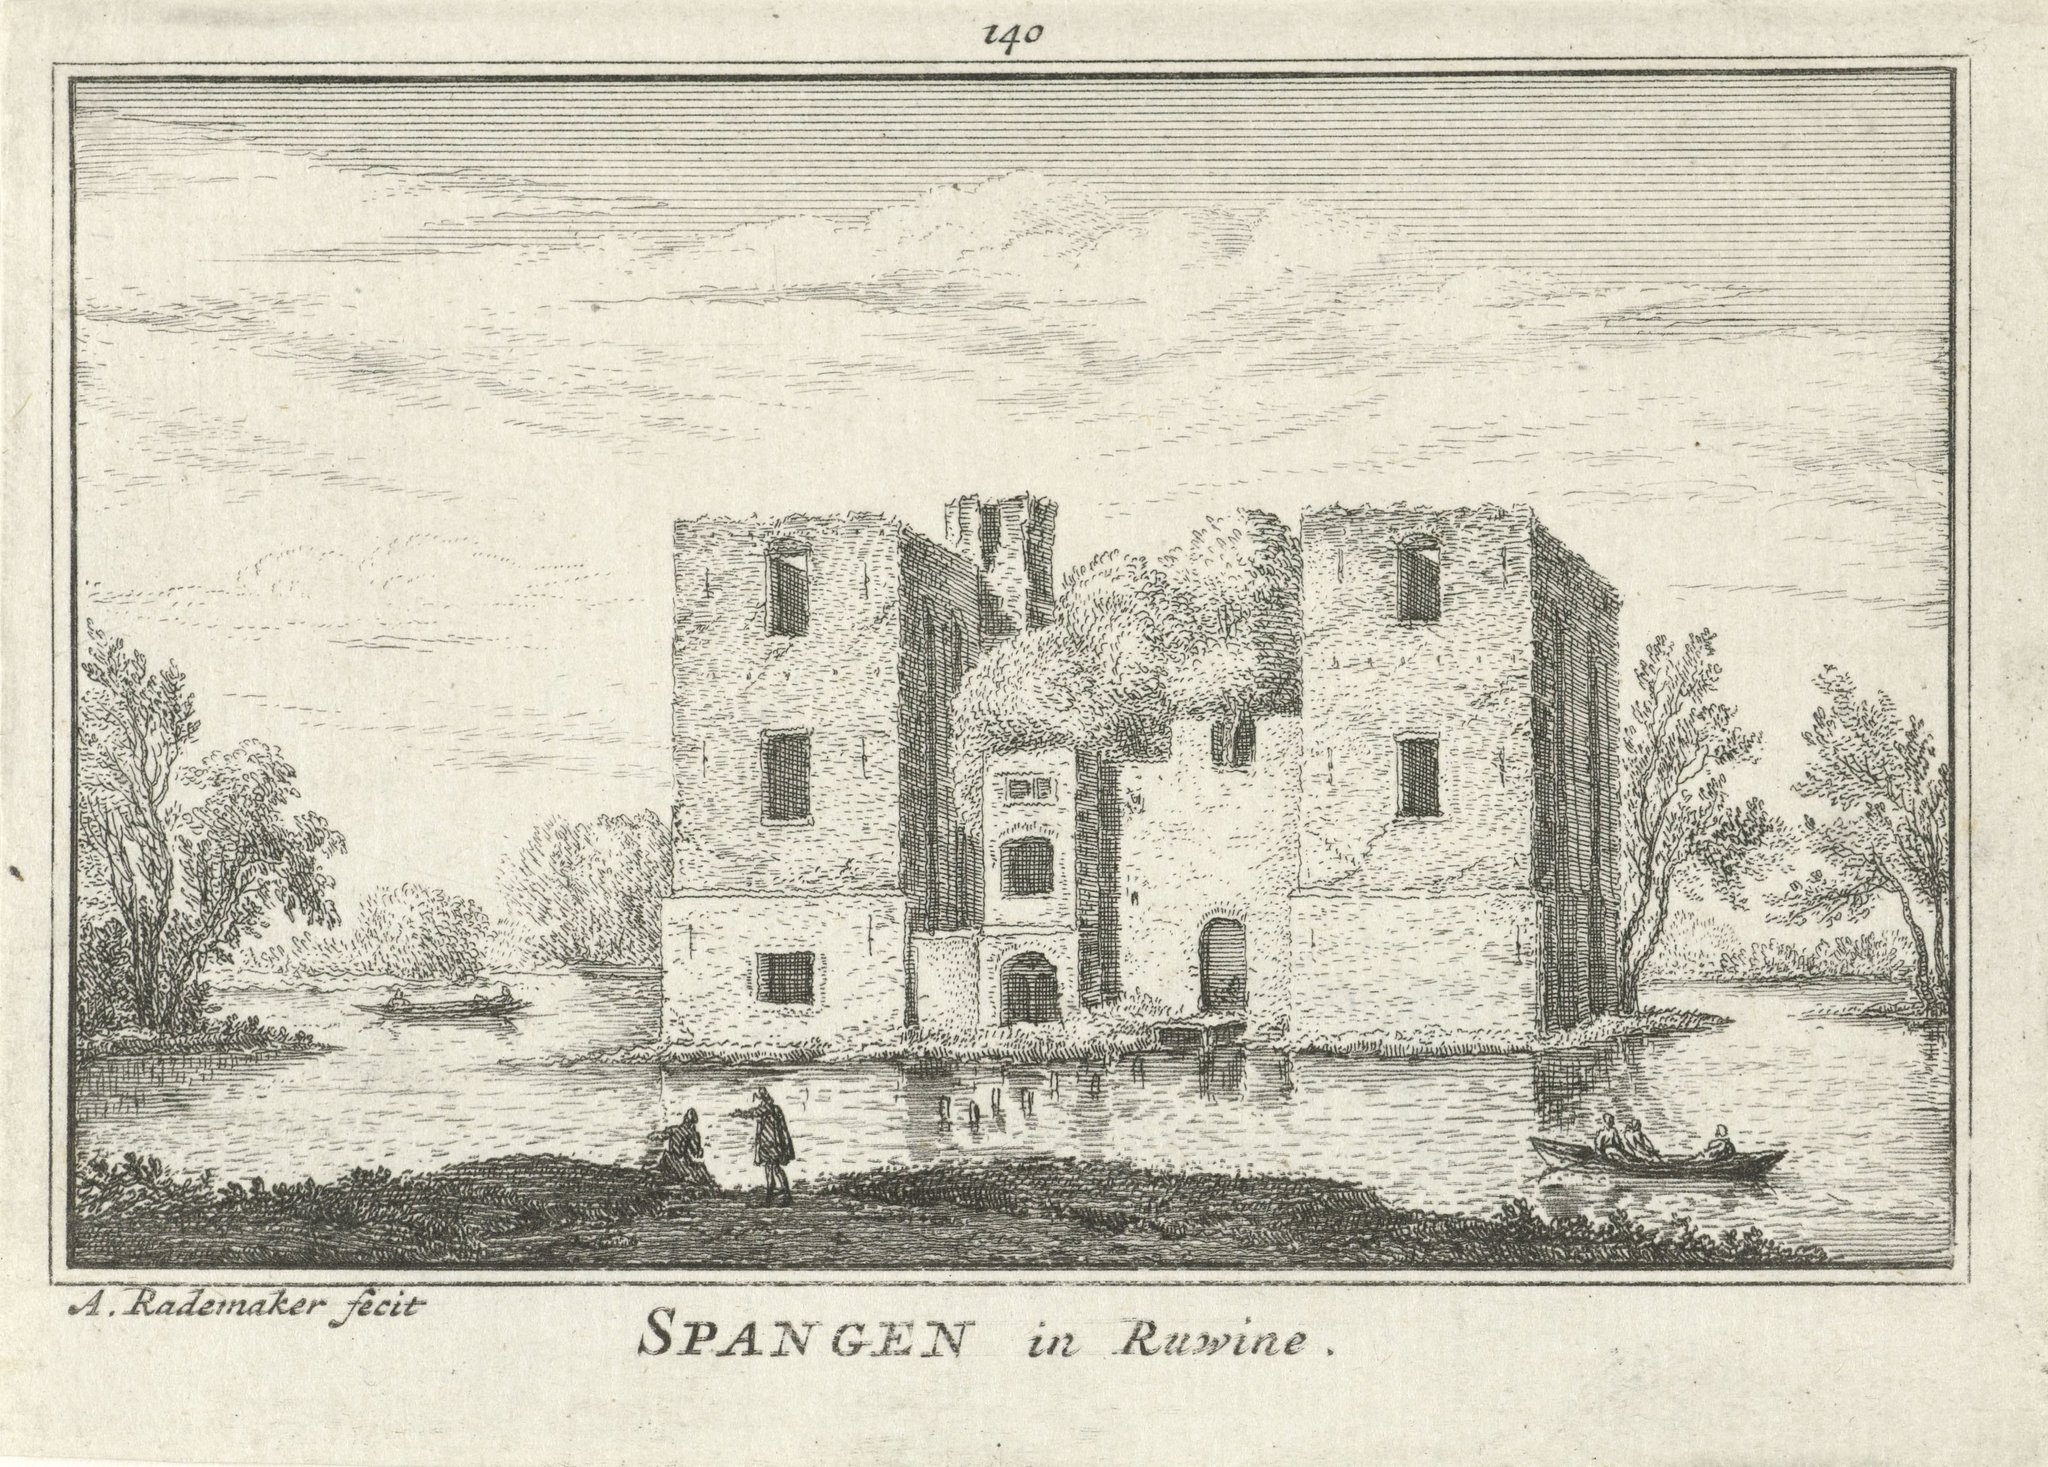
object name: book illustration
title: Gezicht op de ruïne van Kasteel Spangen, 1573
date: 1727-1733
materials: paper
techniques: etching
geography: amsterdam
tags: rowing-boat, canoe, etc., ruin of a dwelling, house, castle, etc.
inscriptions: collector's mark: Lugt 2228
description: Illustratie uit: Abraham Rademaker, Matthaeus Brouërius van Niedek, Isaac Le Long, Kabinet van Nederlandsche en Kleefsche outheden en (...) voorname stads- en landgebouwen, Willem Barents en Antoni Schoonenburg: Amsterdam, 1727-1733, ill. nr. 140.